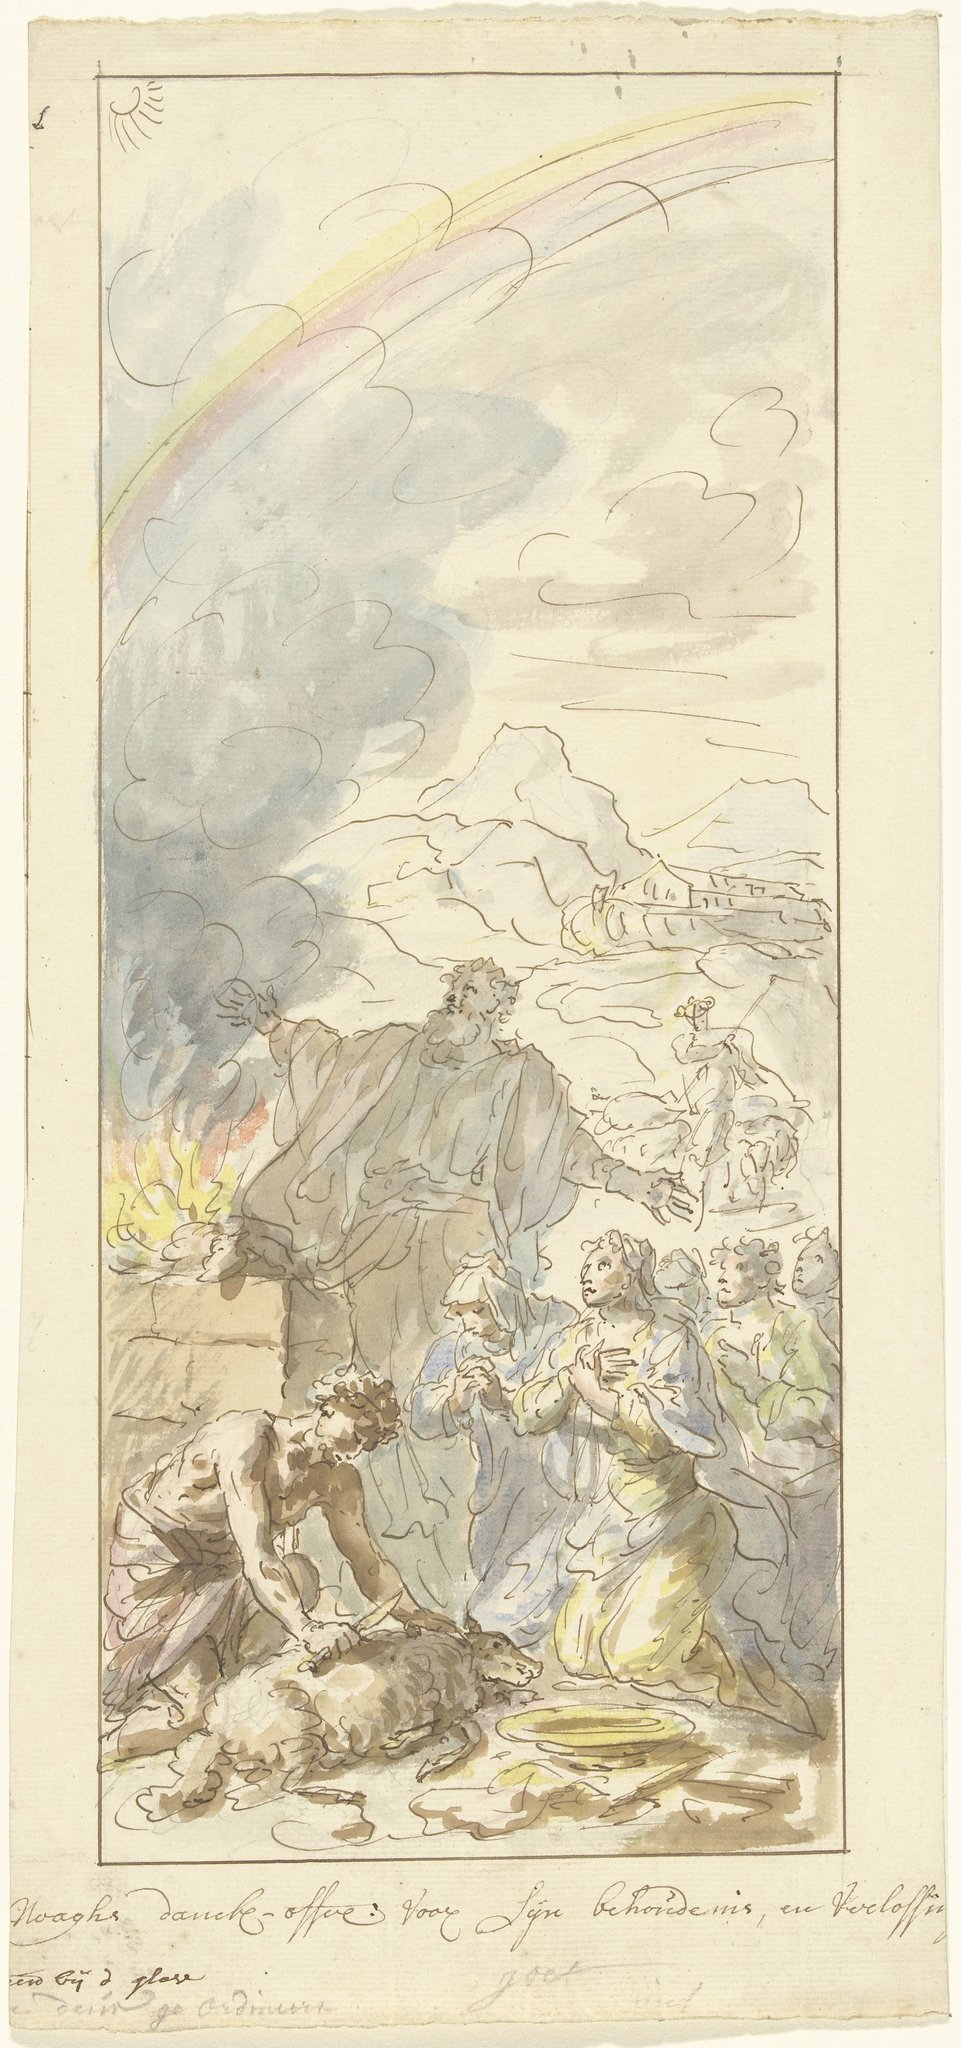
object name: watercolor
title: Noachs dankoffer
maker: elias van nijmegen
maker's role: draughtsman, painter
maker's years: 1667-1755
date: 1677-1755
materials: ink, paper, pencil, watercolor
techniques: brush, pen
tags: noah's sacrifice; various animals are offered, possibly a lamb, a dove and a ram (often combined with the rainbow of the covenant)